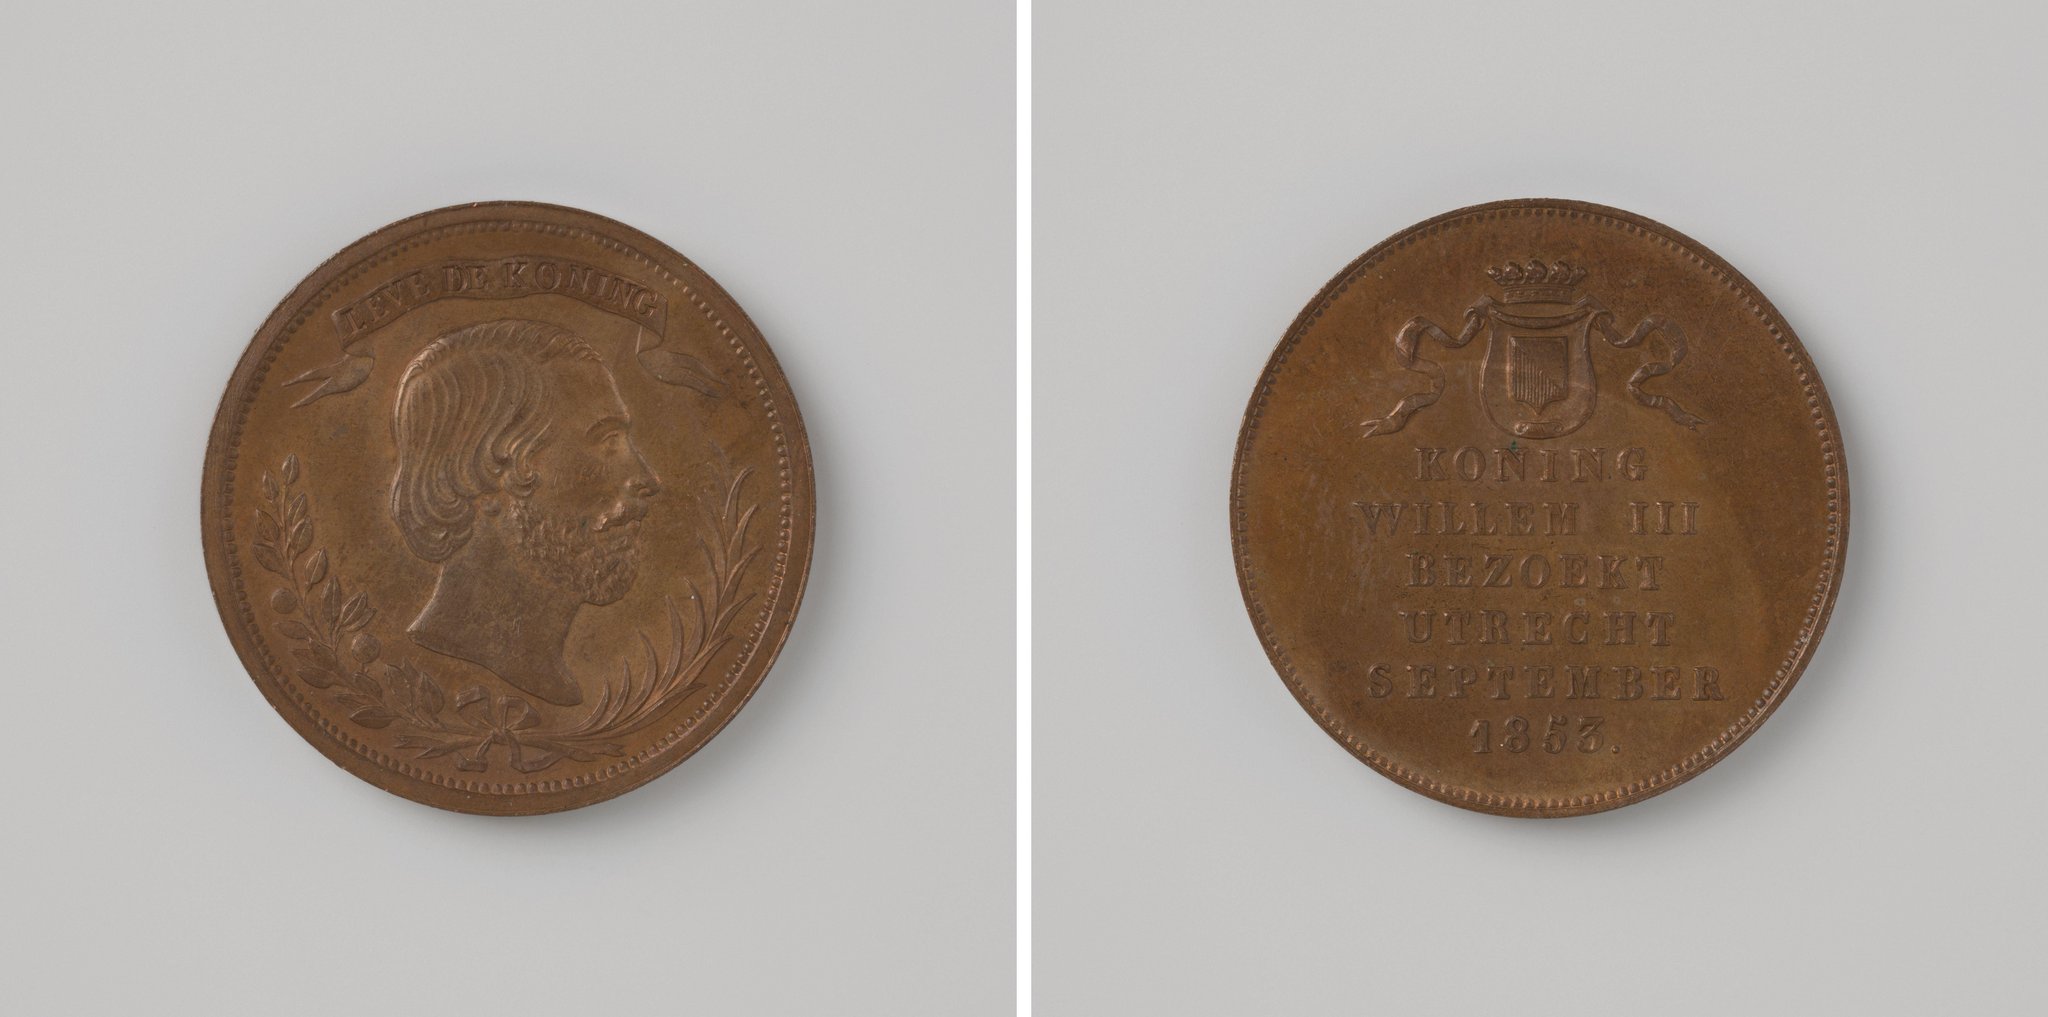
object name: history medal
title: Bezoek van Koning Willem III aan Utrecht 1853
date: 1853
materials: bronze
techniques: striking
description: Bronzen penning, op de voorzijde het muntportret van Willem III naar rechts met onder een samengestrikte oranje- en palmtak en bven een lint met LEVE DE KONING, op de keerzijde zes regels tekst onder een gekroond schild met linten en het wapen van de stad Utrecht.